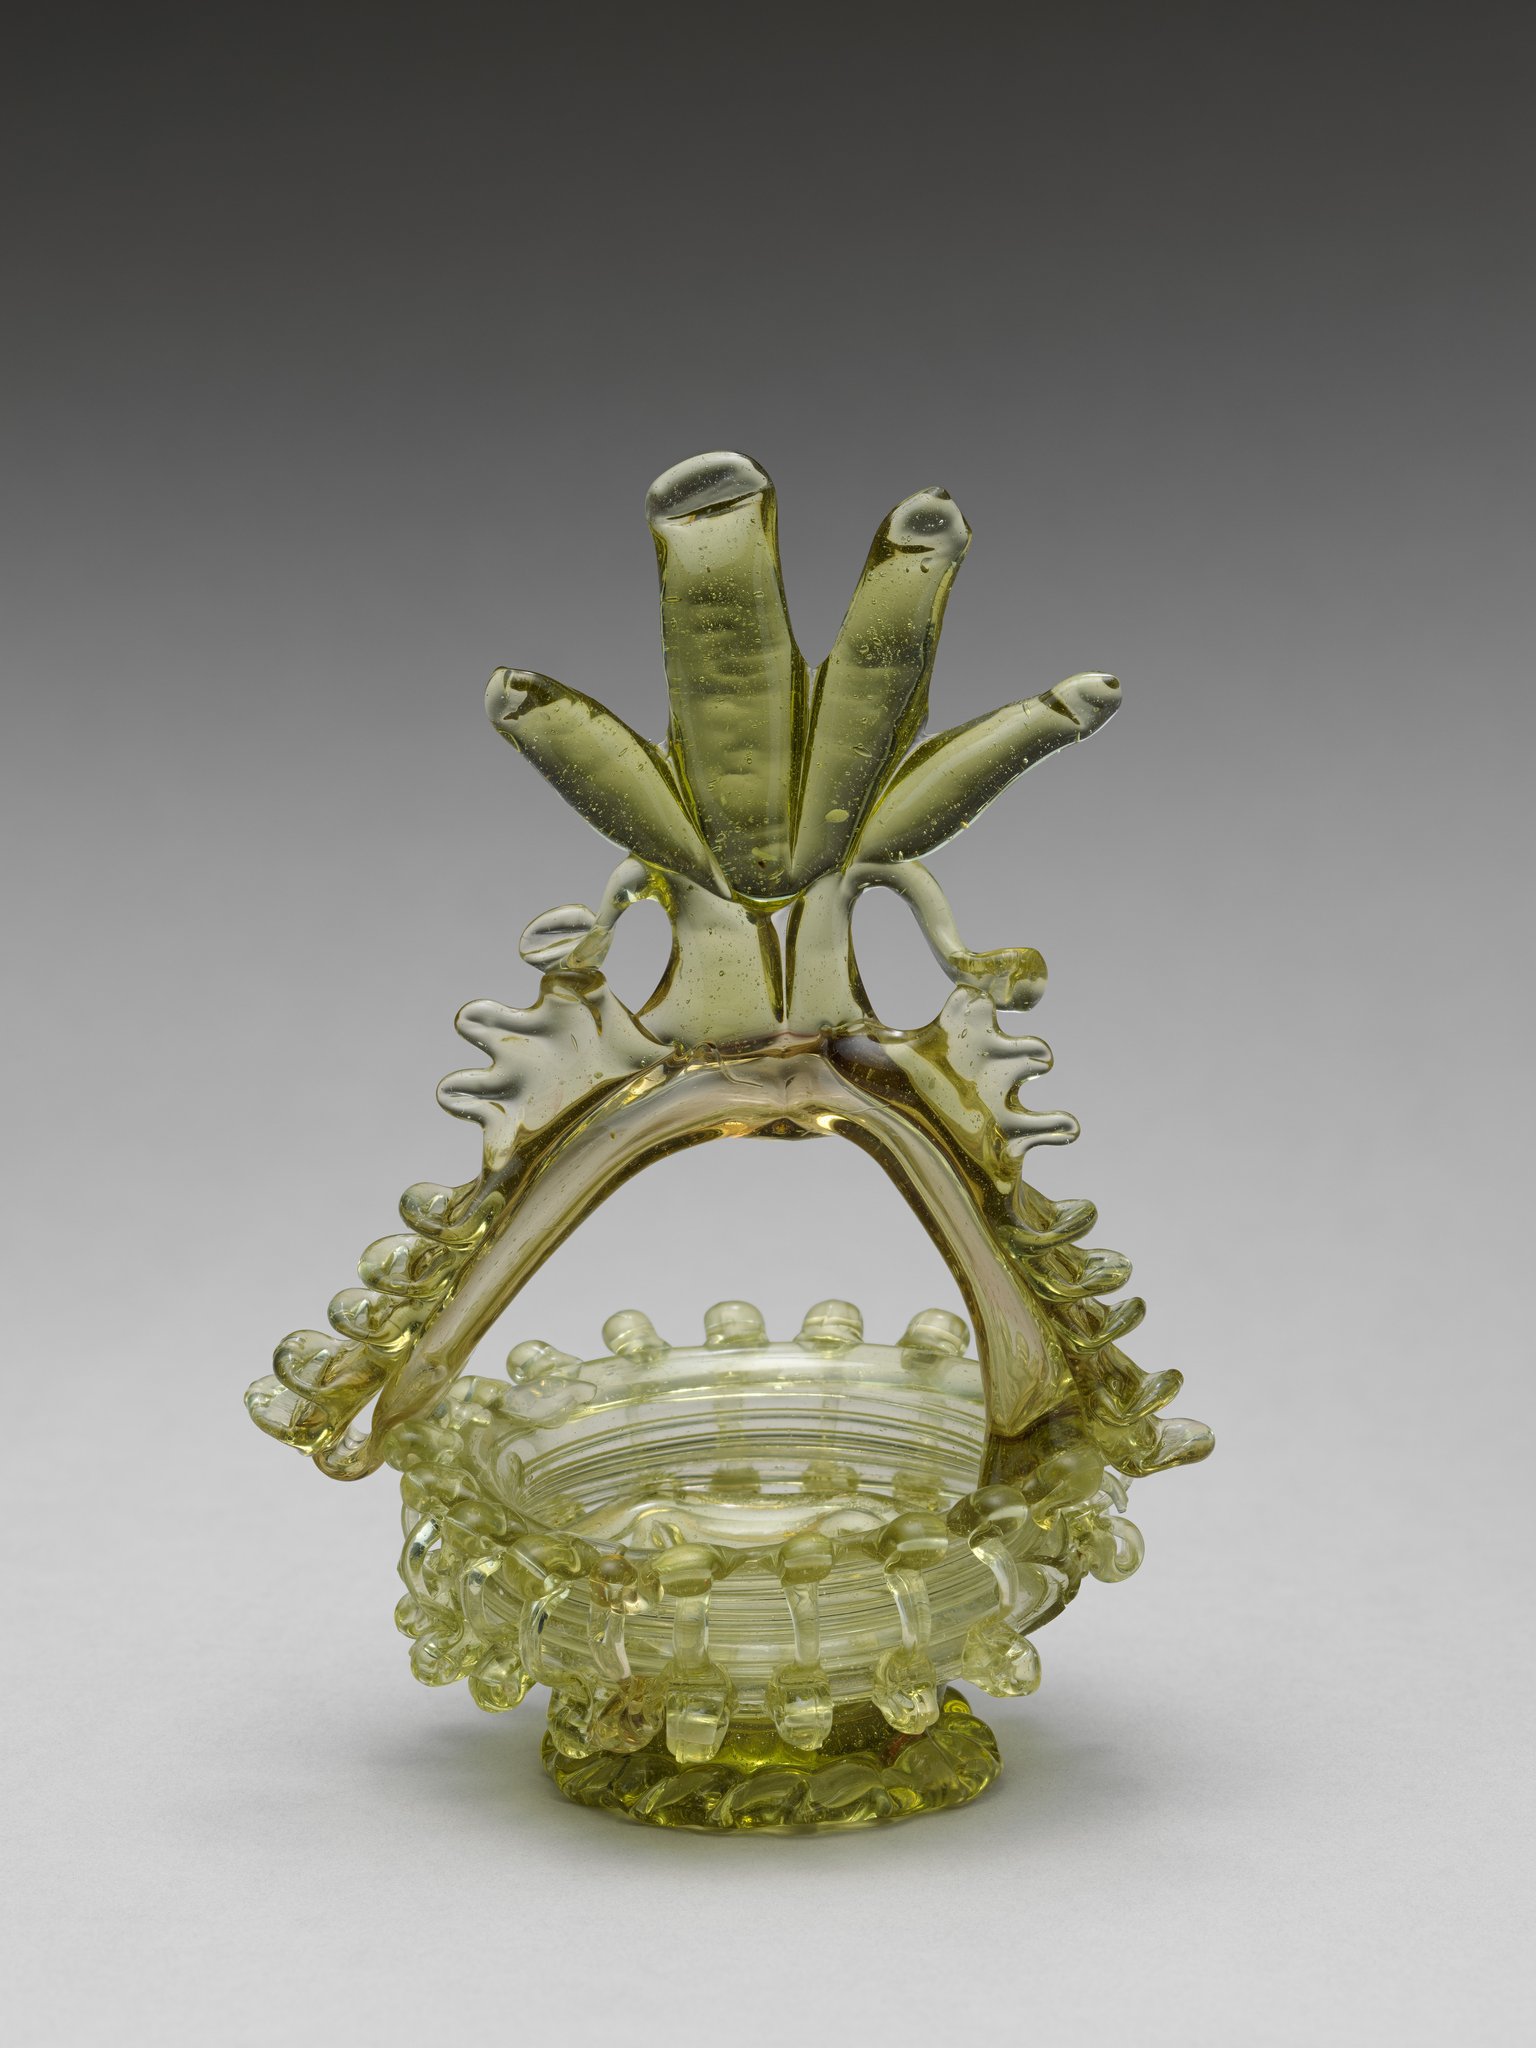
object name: basket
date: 1601-1700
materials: glass